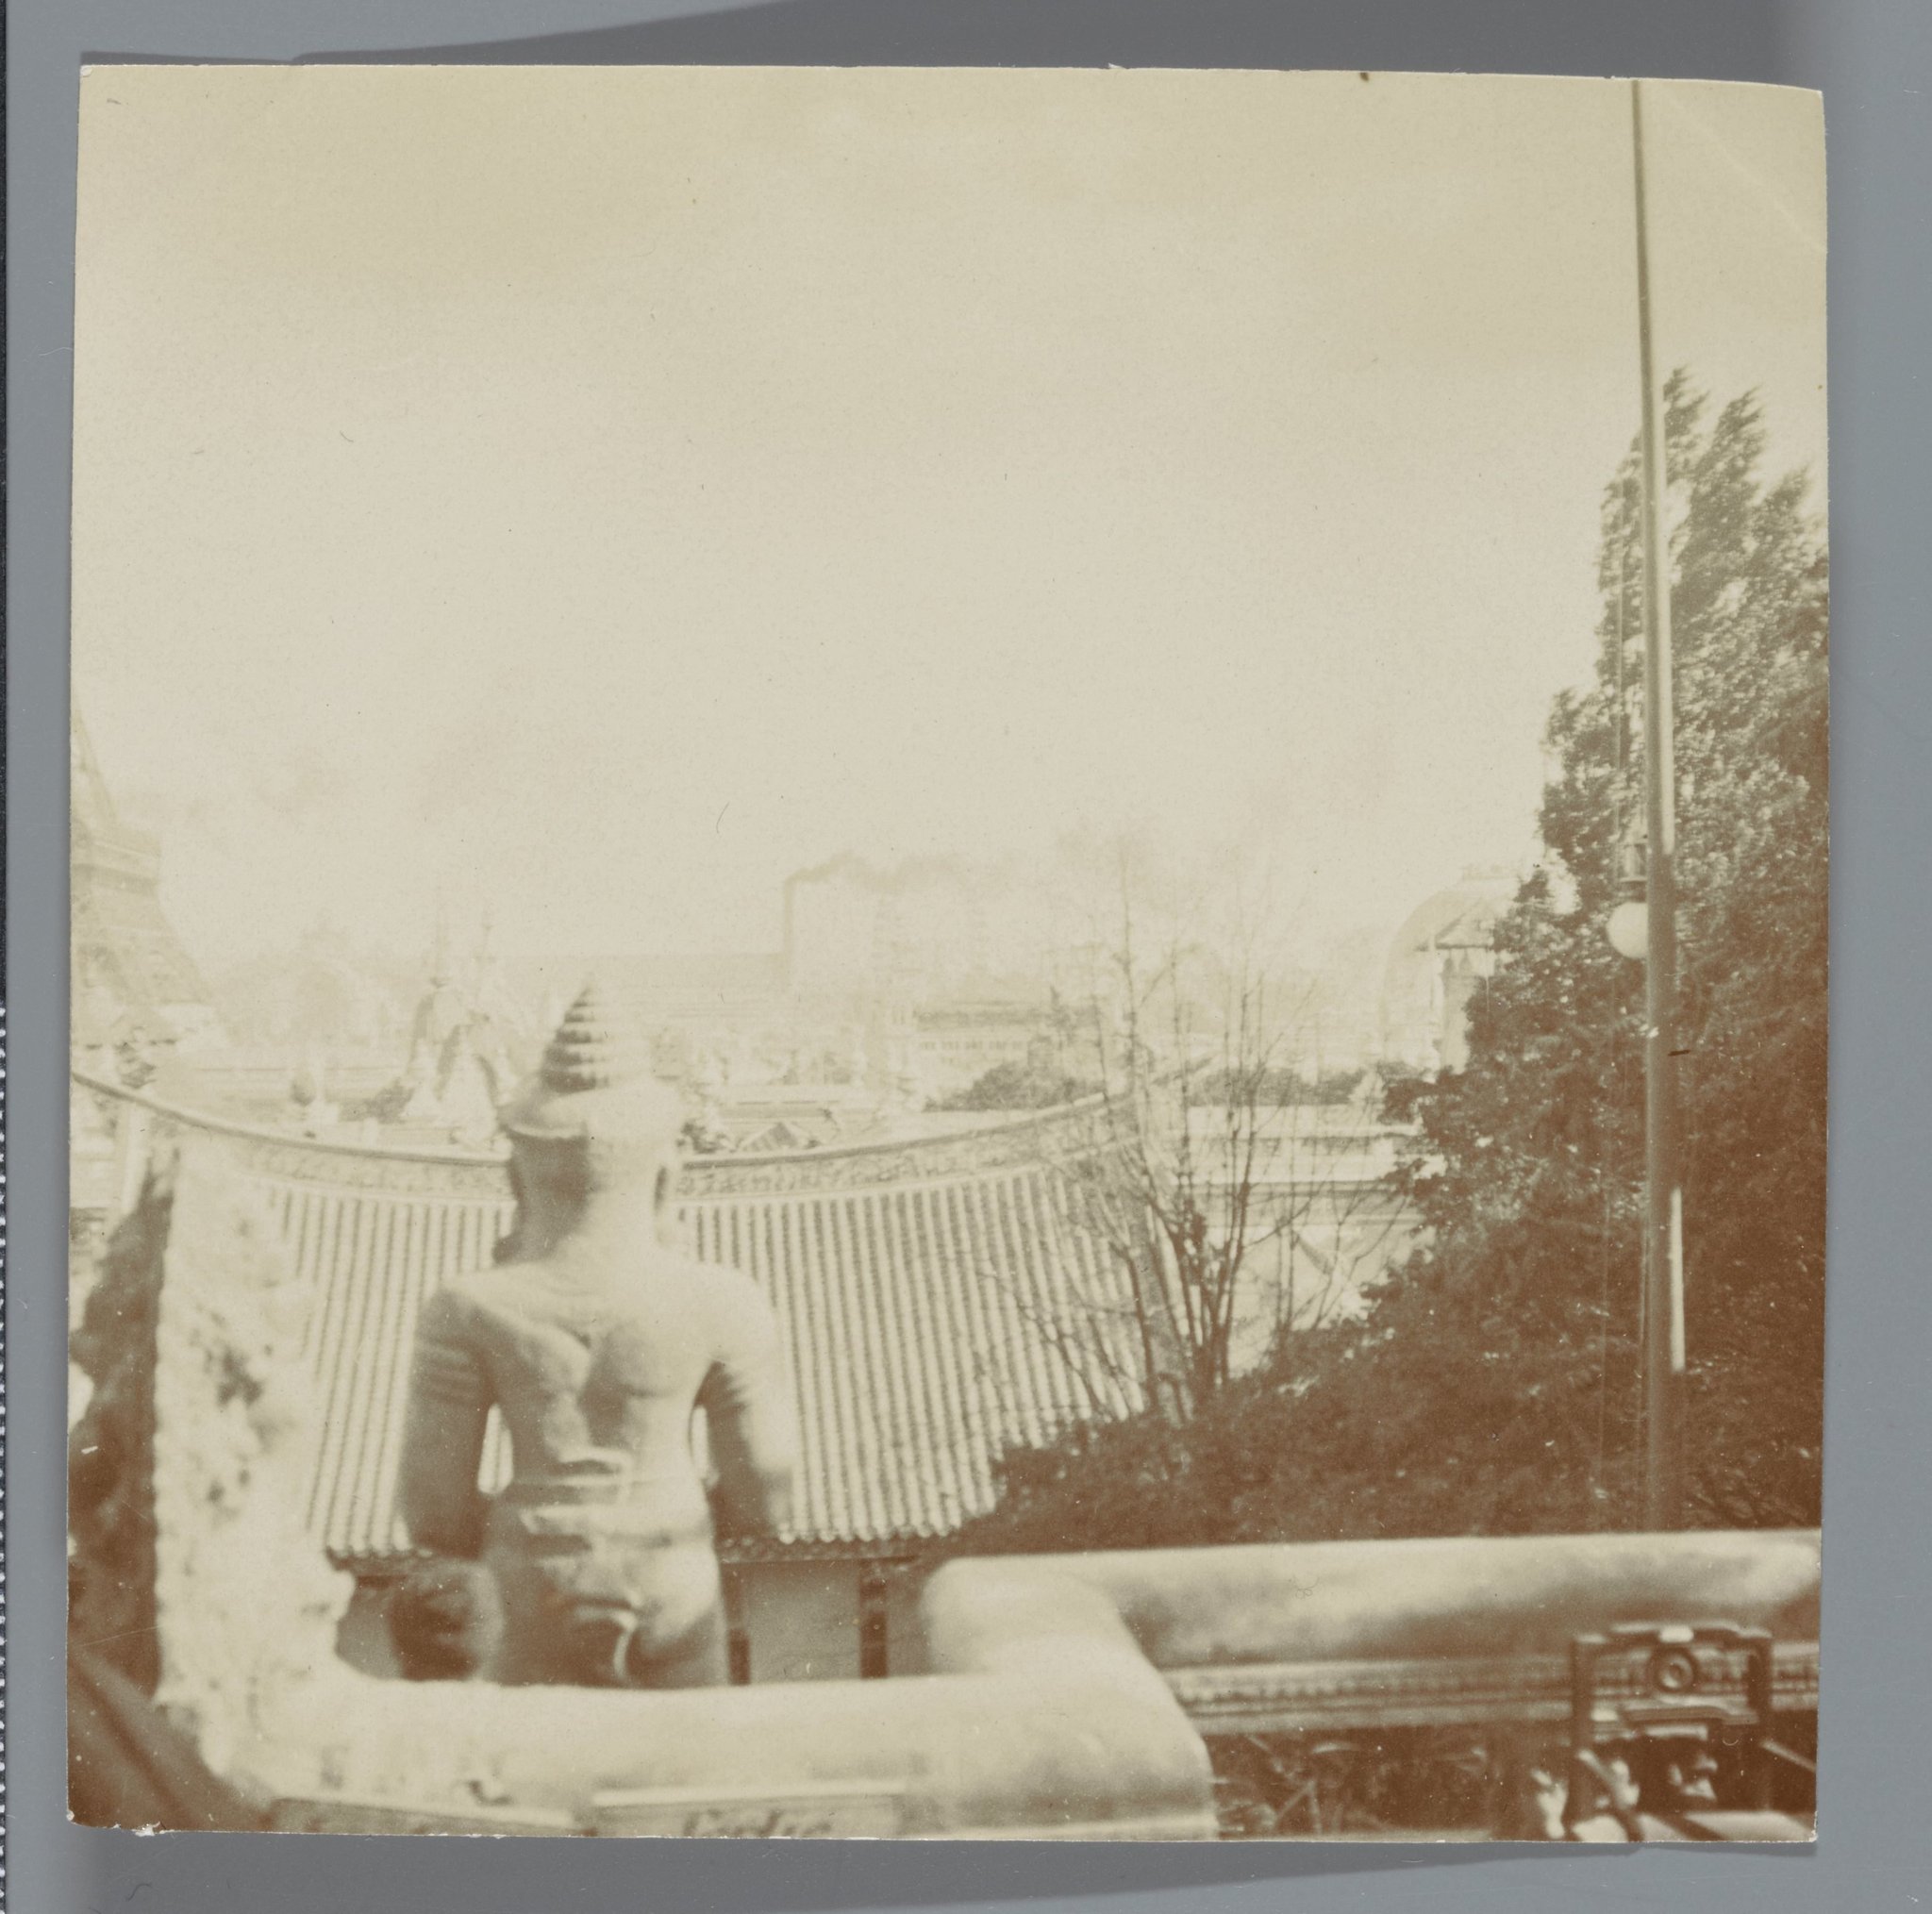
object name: photograph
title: Gezicht op een paviljoen op de Exposition Universelle (Wereldtentoonstelling), Parijs, Frankrijk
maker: Anonymous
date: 1900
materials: paper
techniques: gelatin silver print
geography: france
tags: world fair, world exhibition, france, paris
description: Gezicht op een paviljoen op de Exposition Universelle (Wereldtentoonstelling), Parijs, Frankrijk.